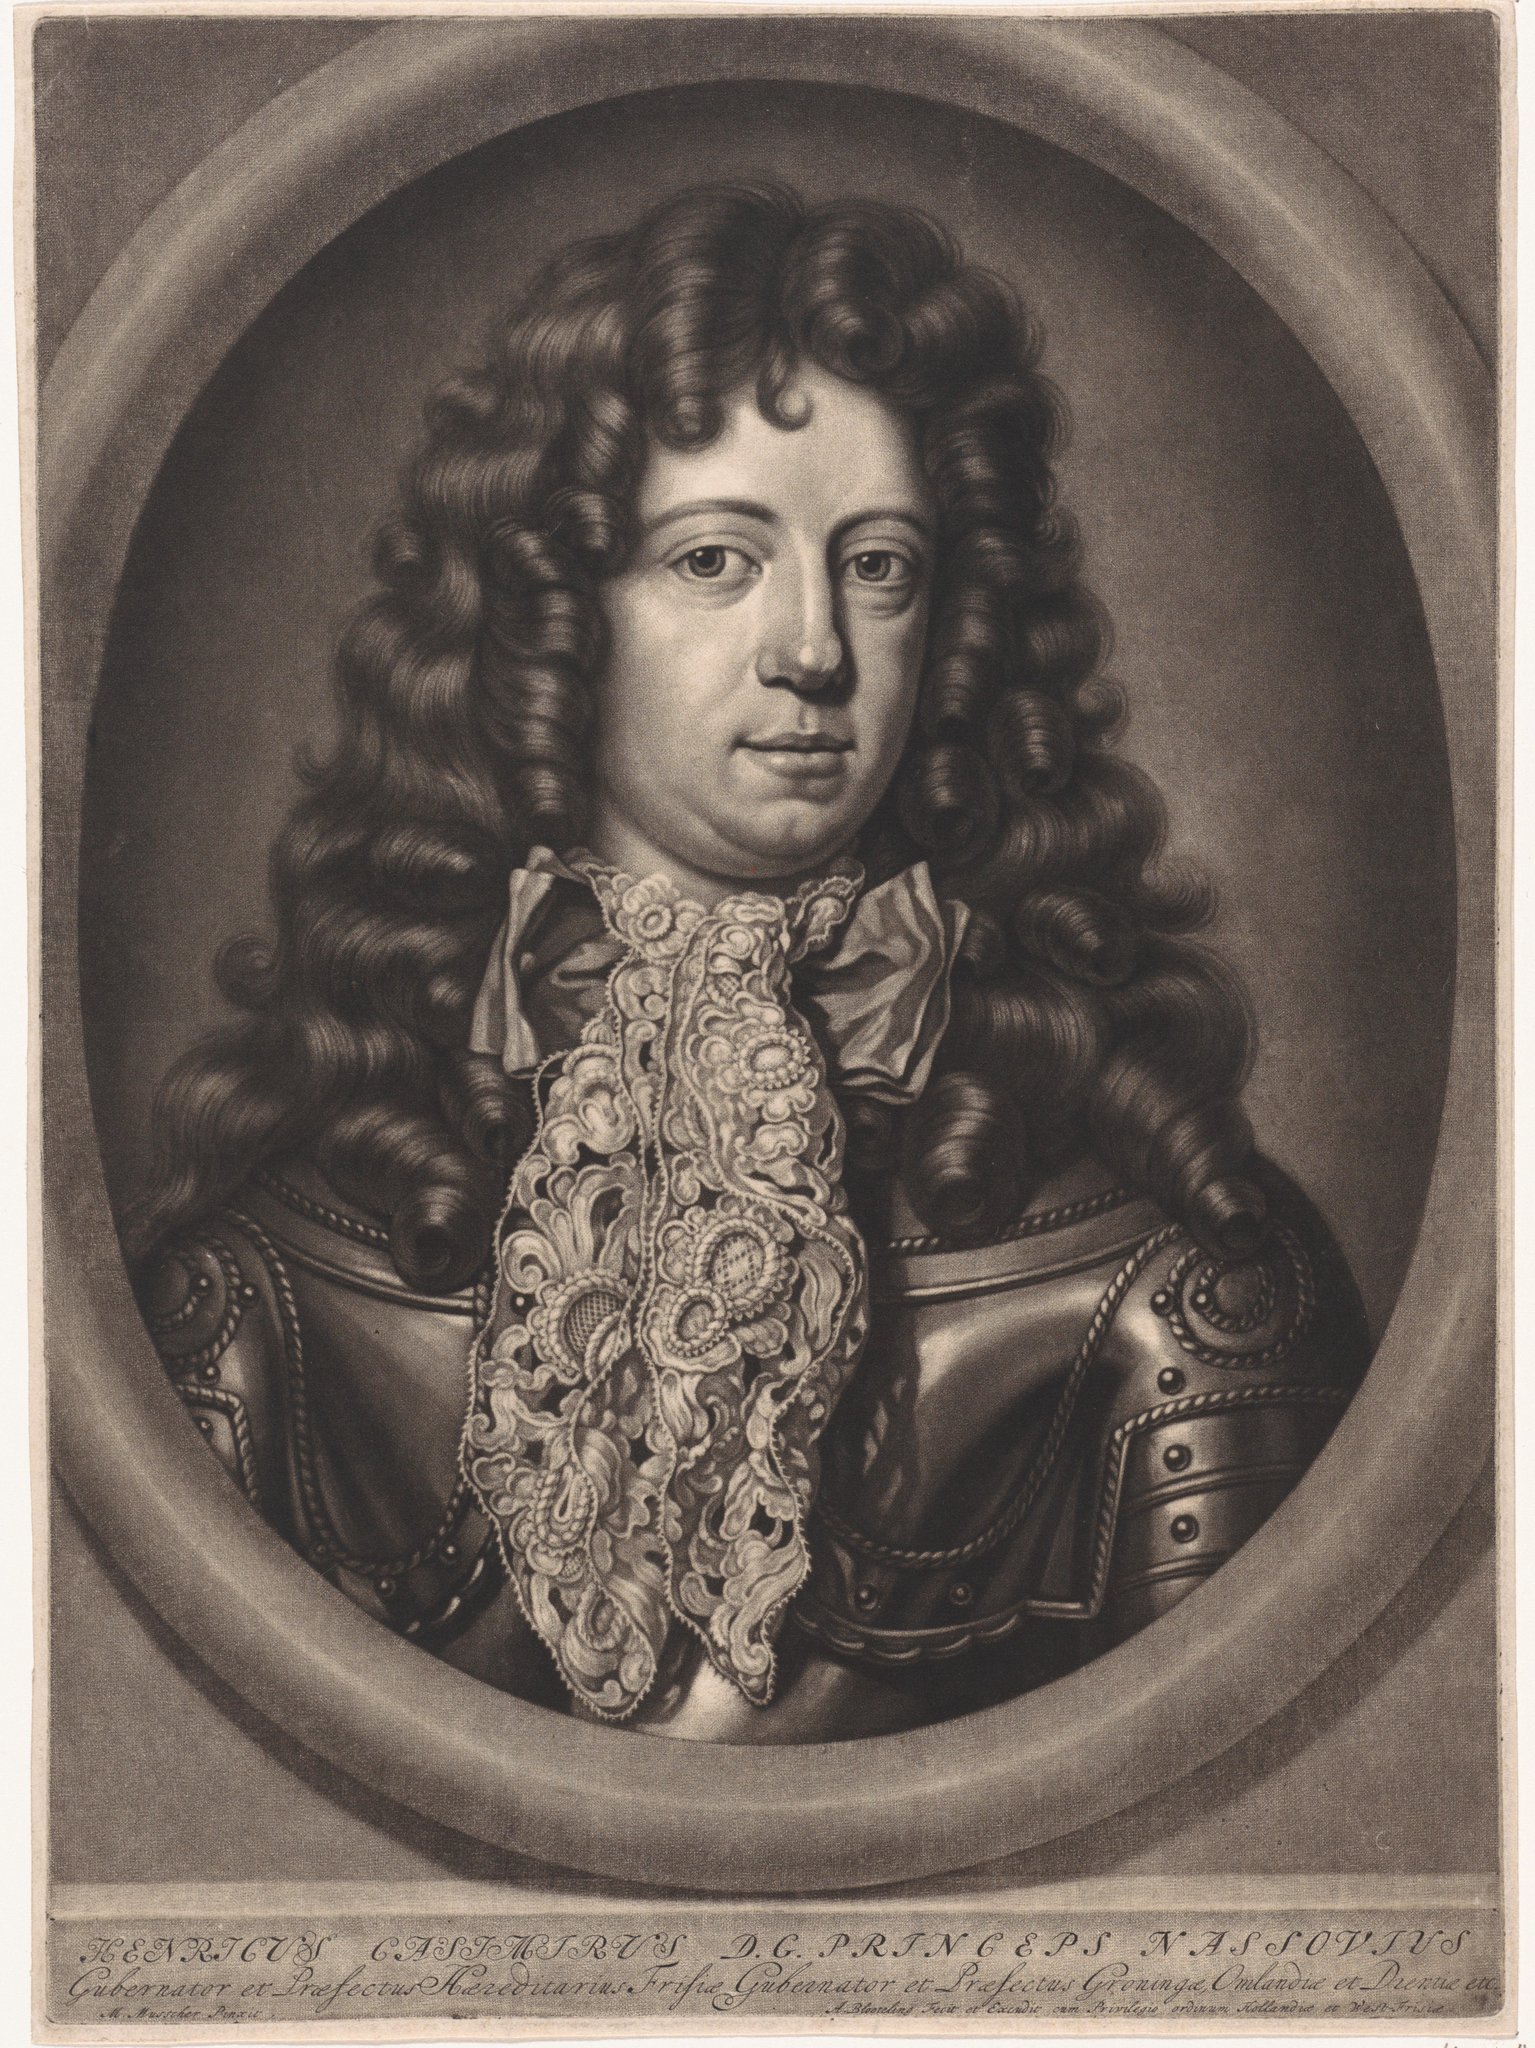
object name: print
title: Portret van Hendrik Casimir II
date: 1664-1690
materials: paper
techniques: engraving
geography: amsterdam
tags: hendrik casimir ii graaf van nassau-dietz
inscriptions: collector's mark: Lugt 2228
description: Portret van Hendrik Casimir II, graaf van Nassau-Dietz en stadhouder van Friesland, Groningen en Drente.